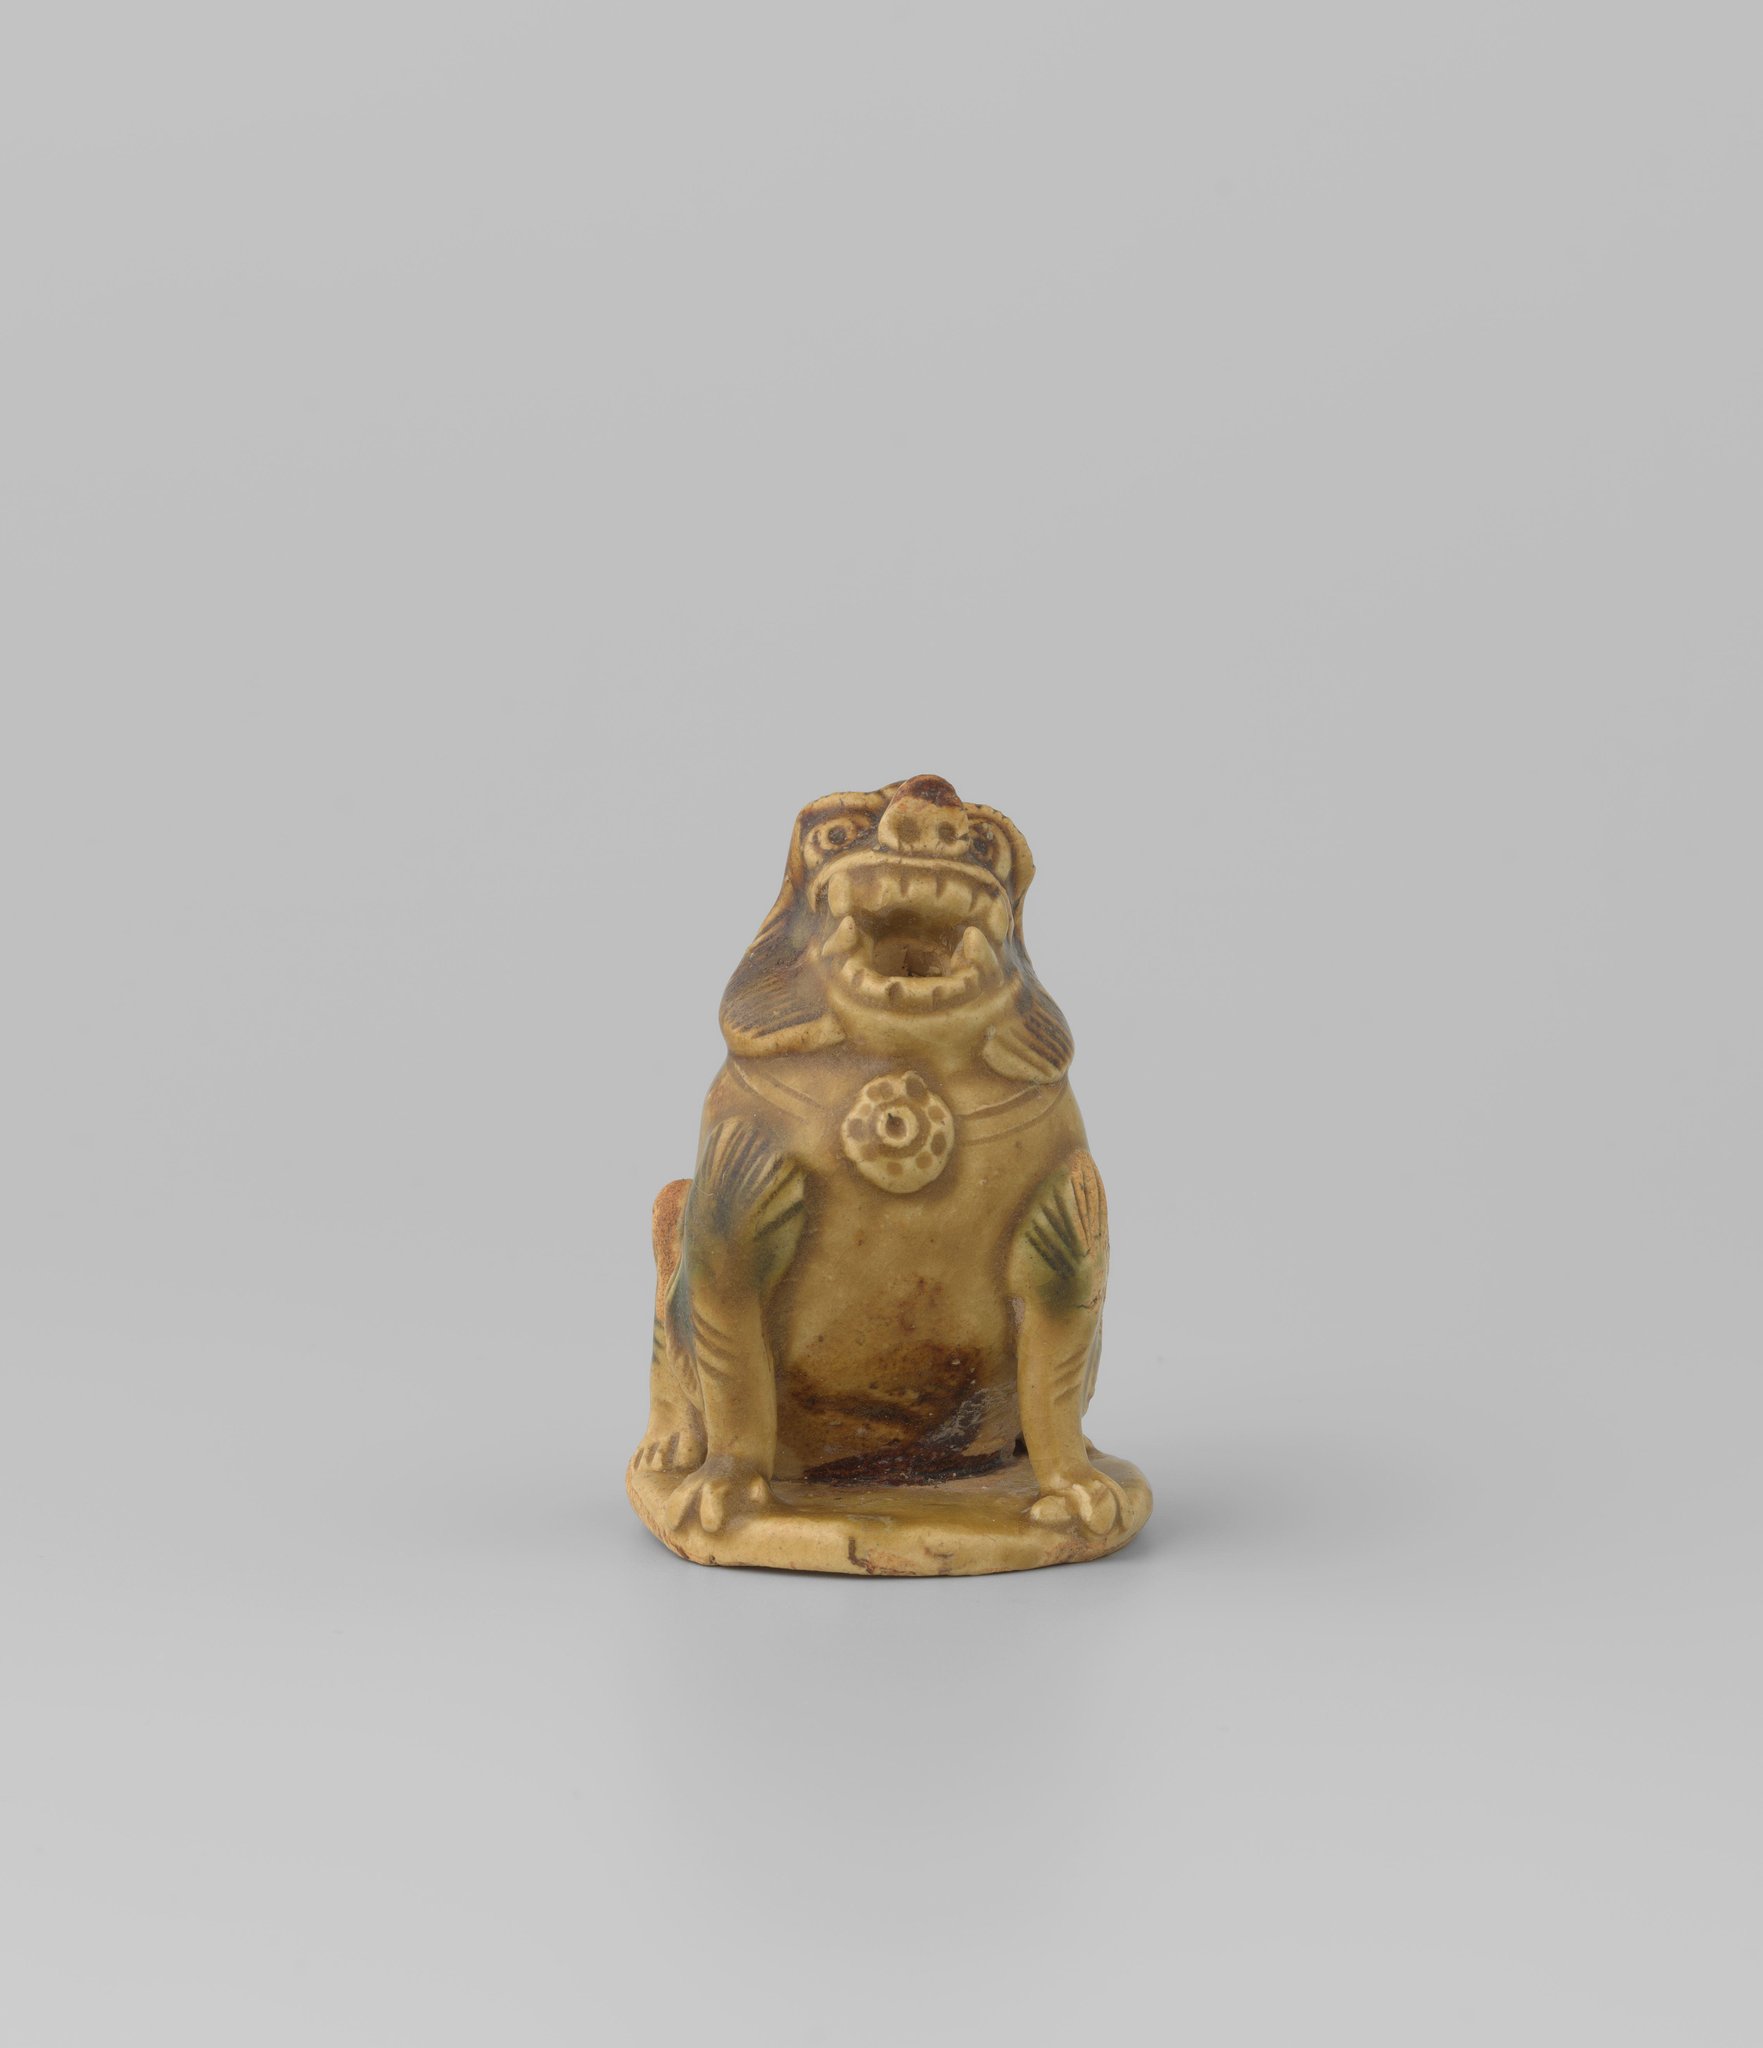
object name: miniature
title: Roaring Buddhistic Lion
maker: Anonymous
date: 618-907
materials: earthenware, putty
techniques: firing, forming, vitrification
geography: china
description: AK-MAK-1808 Vergelijk: Lam 1990, figs. 225-549. Zie voor de volledige titels de literatuurlijst in J.W.M. (Koos) de Jong, Vroege Chinese miniaturen. De ontsluiting van een cultureel fenomeen (proefschrift UvA), Amsterdam, 2020.